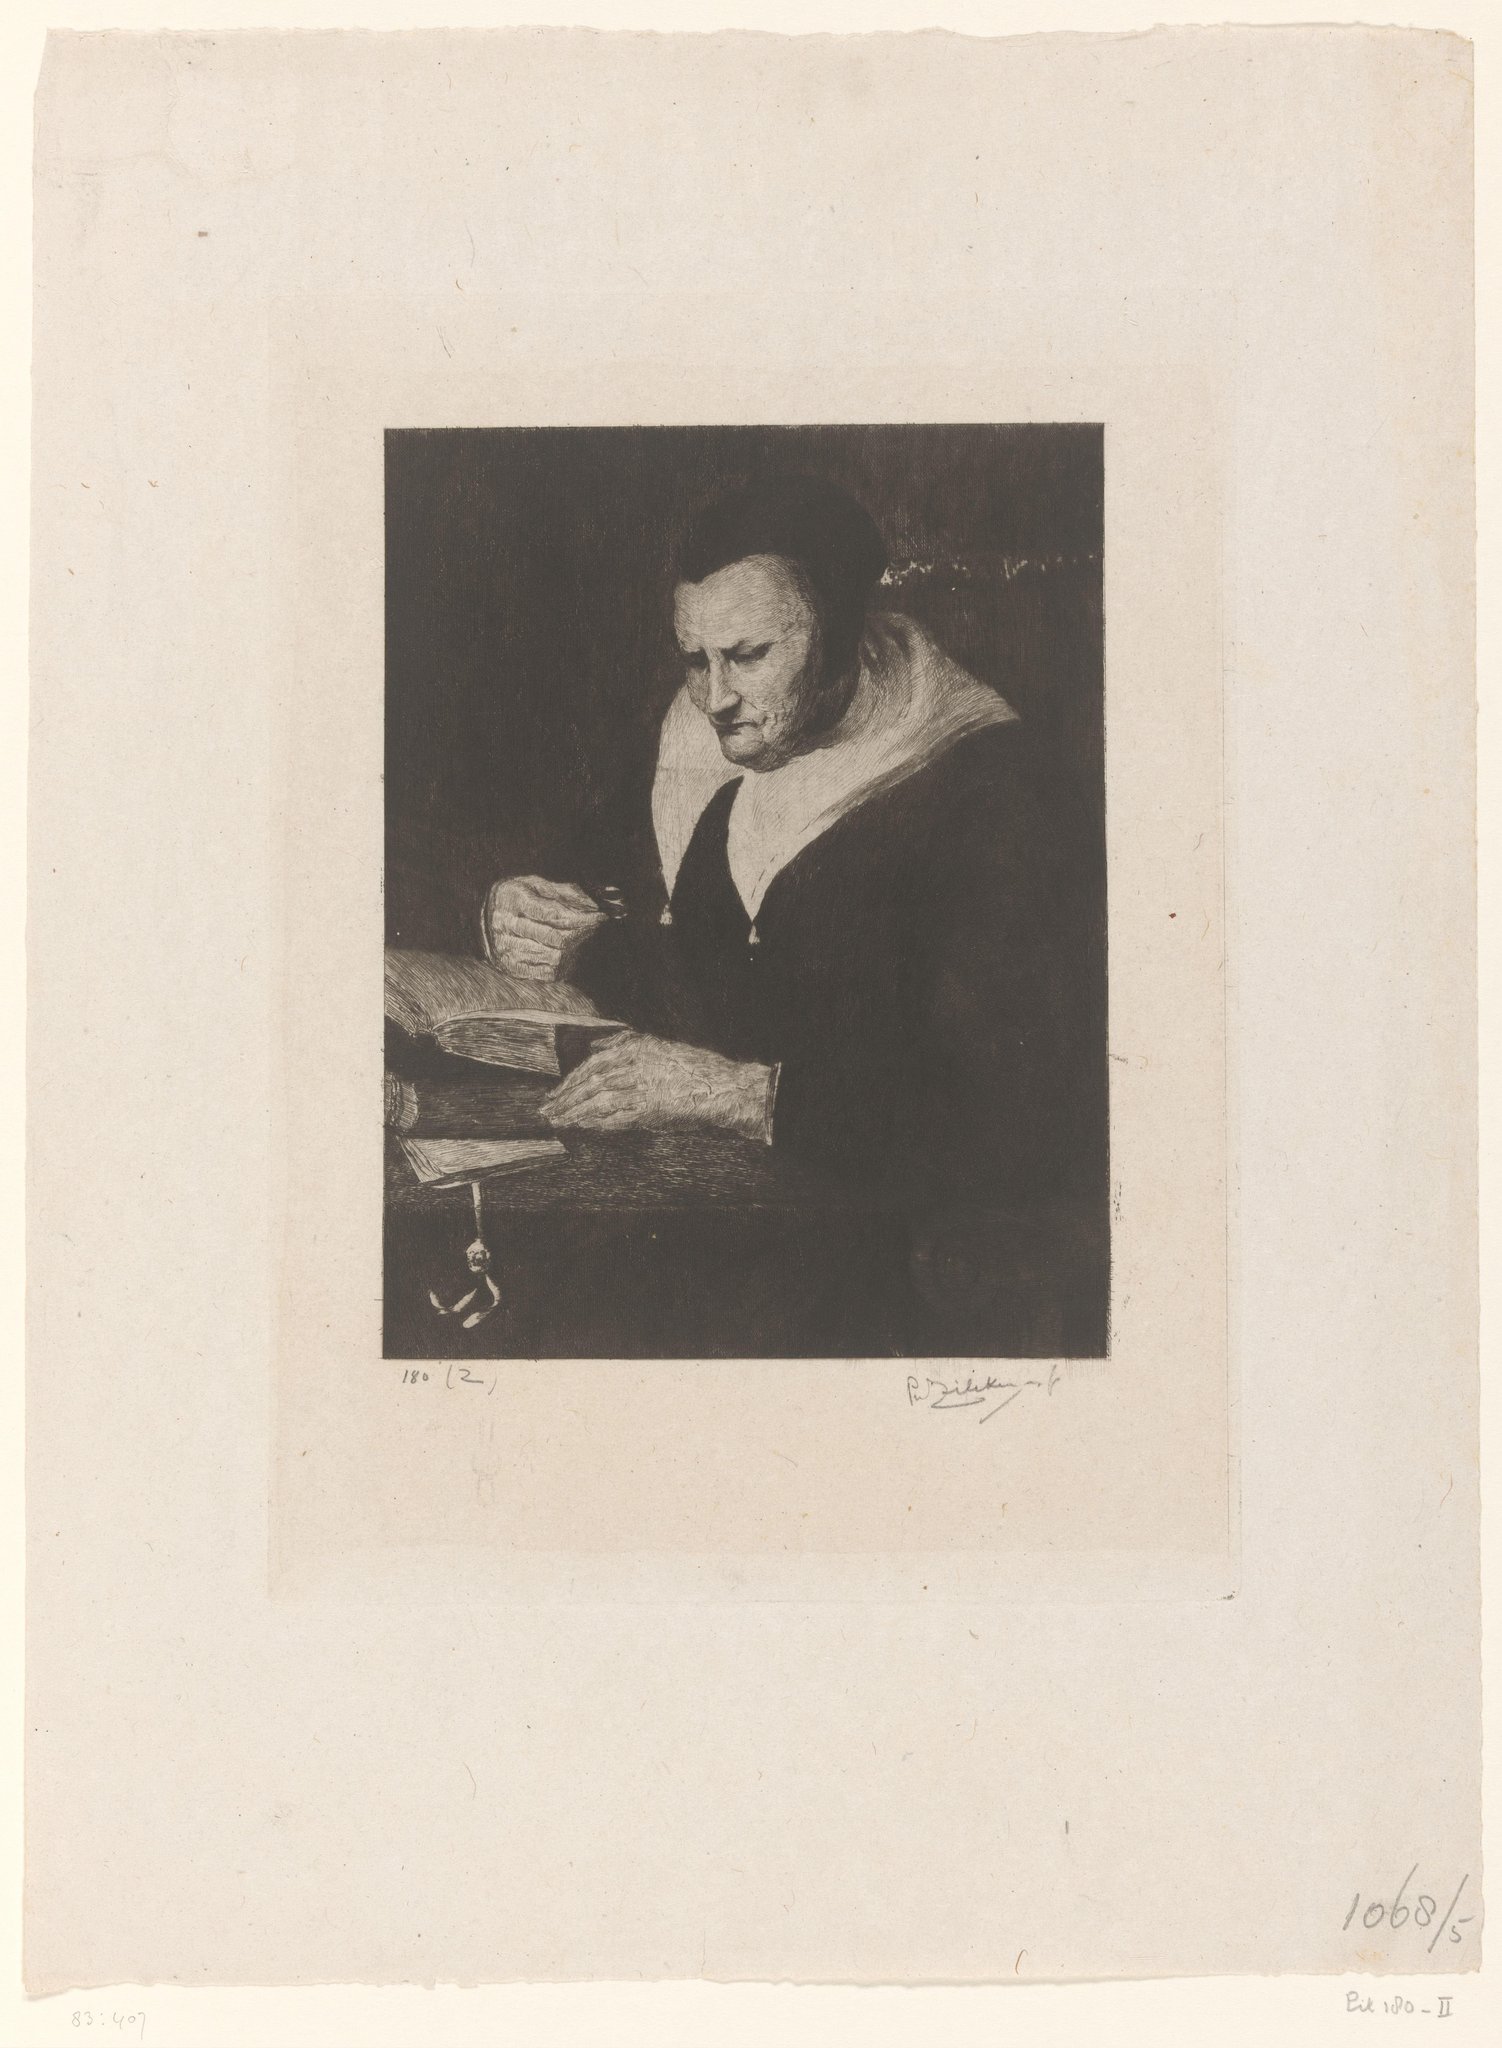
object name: print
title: Vieille femme lisant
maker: philip zilcken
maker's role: draughtsman, painter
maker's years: 1857-1930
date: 1867-1890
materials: paper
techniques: drypoint, etching, intaglio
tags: reading, old woman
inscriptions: collector's mark: Lugt 2228